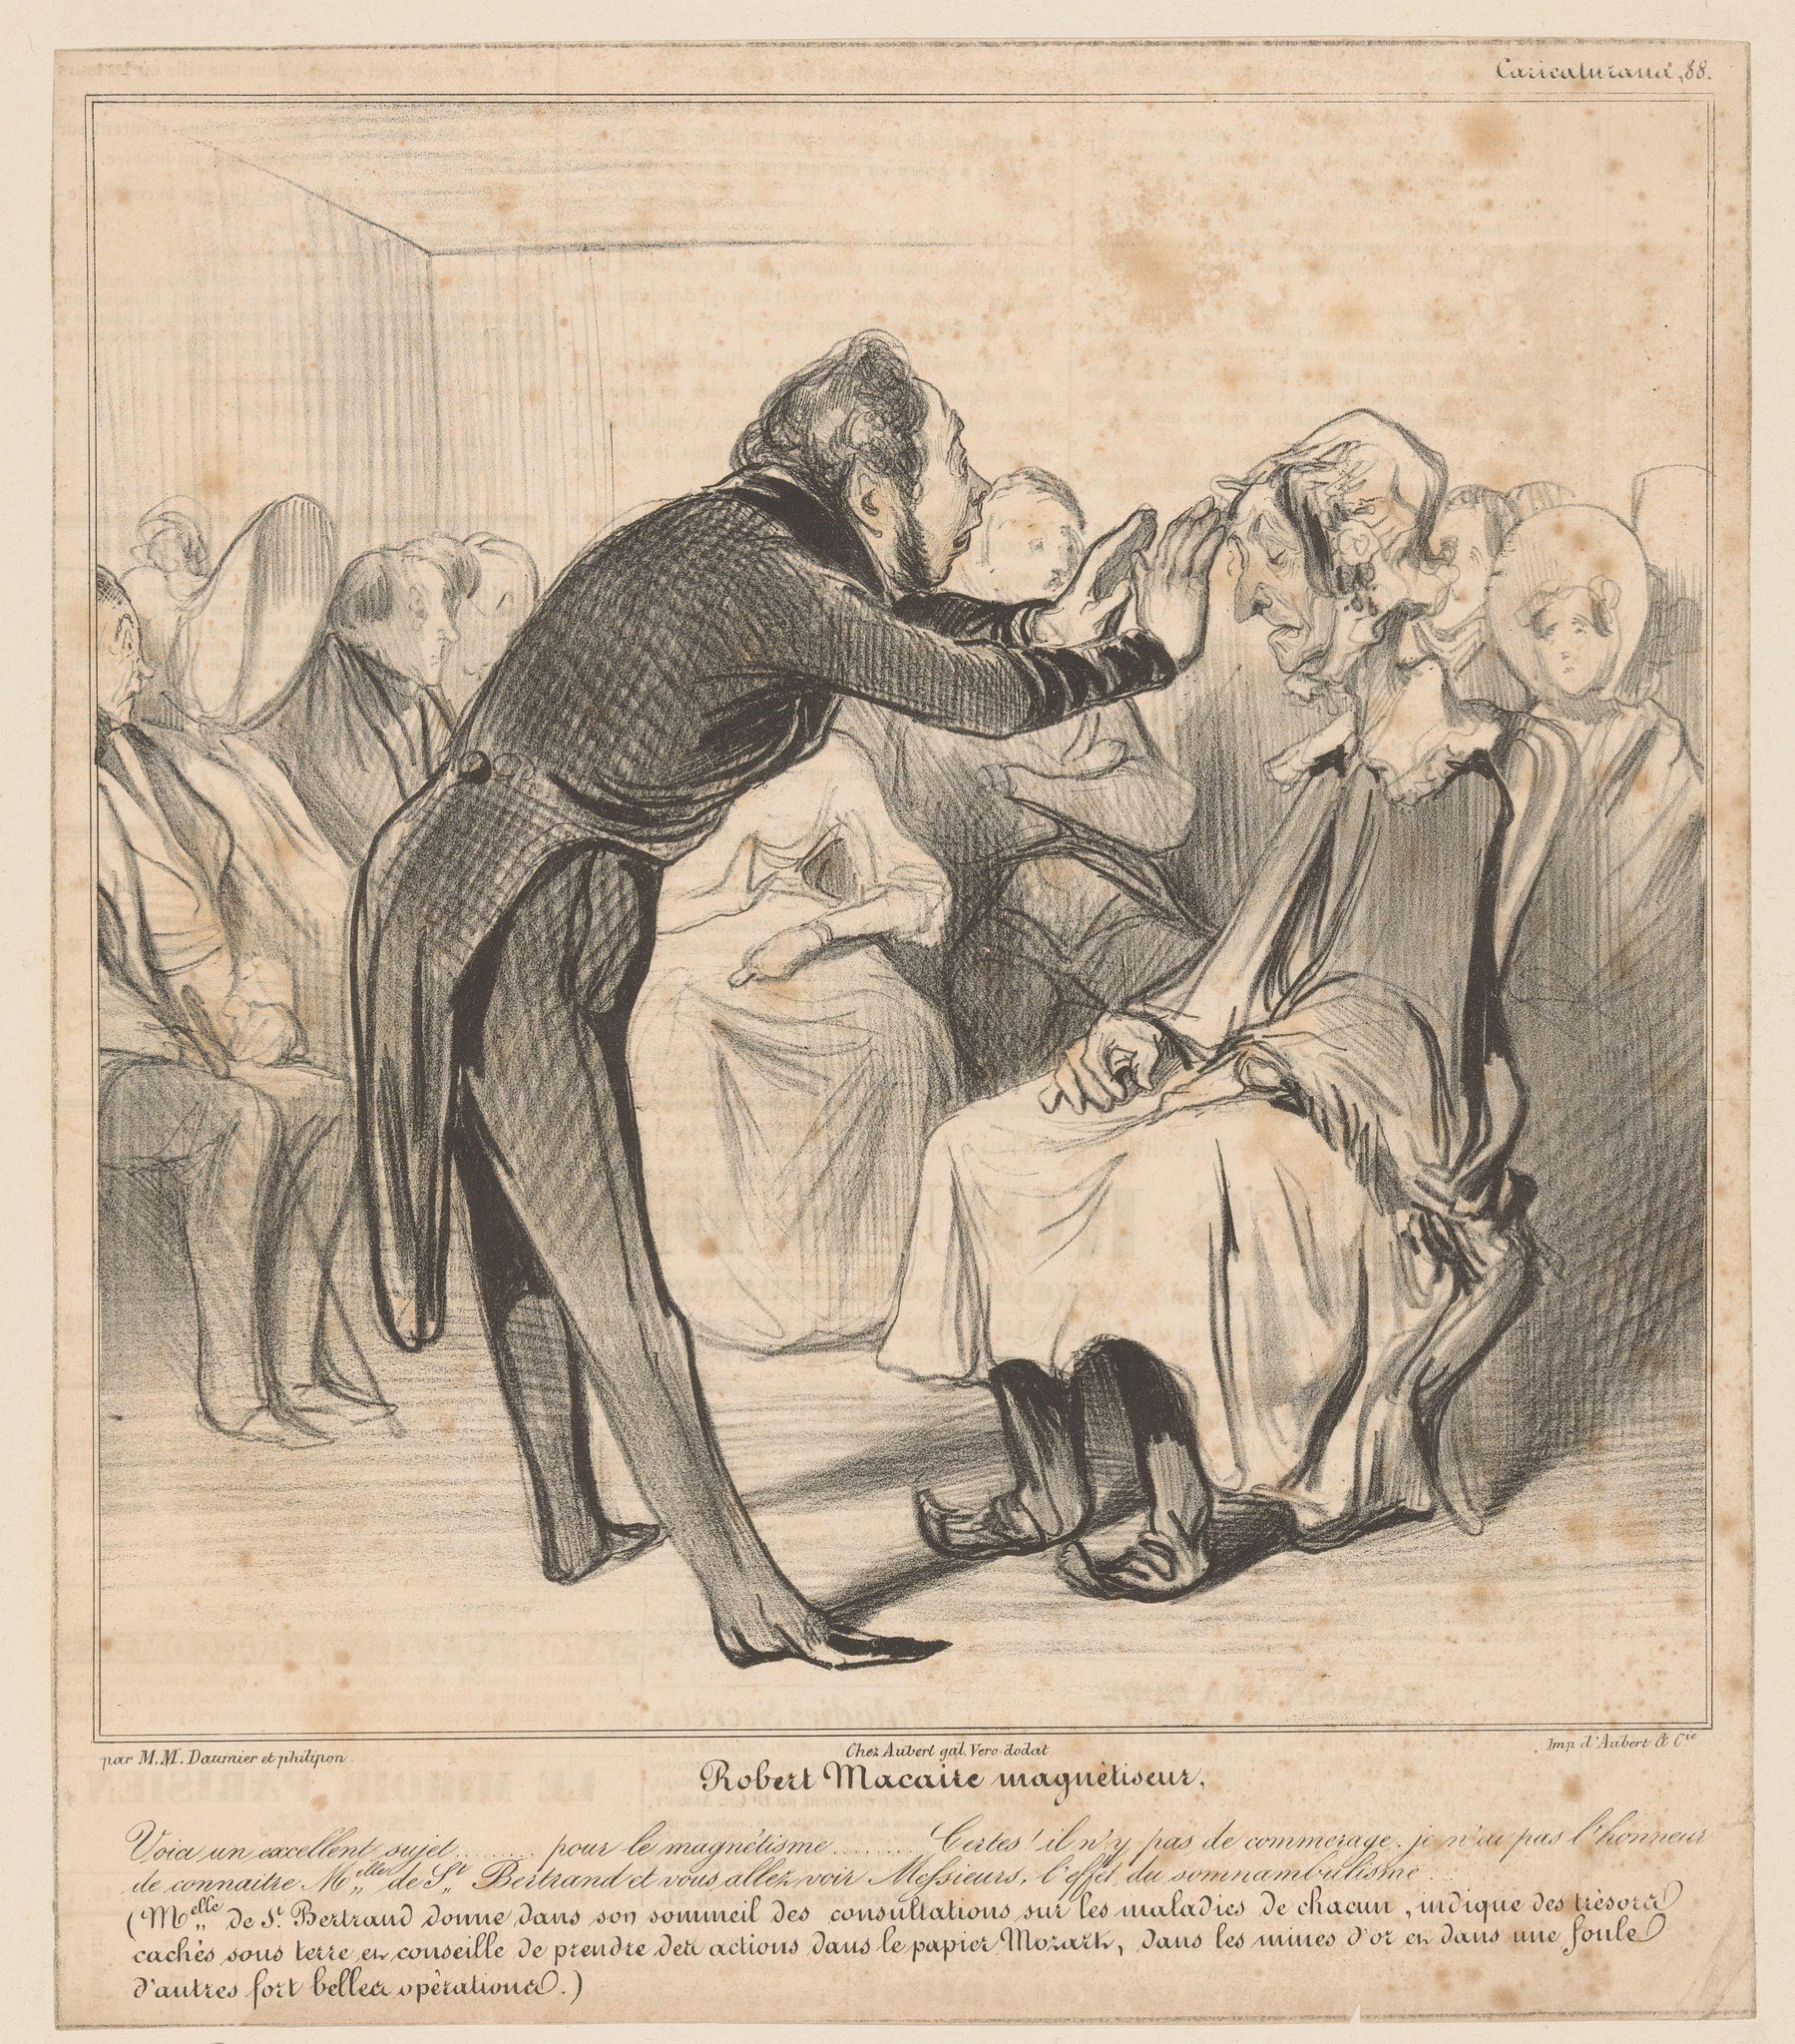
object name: cartoon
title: Robert Macaire magnetiseert Bertrand, vermomd als oude vrouw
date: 1838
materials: paper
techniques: letterpress printing, lithograph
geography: paris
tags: magic healings, caricatures (human types), disguise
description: Prent mogelijk uit: Le Charivari, 26 augustus 1838.